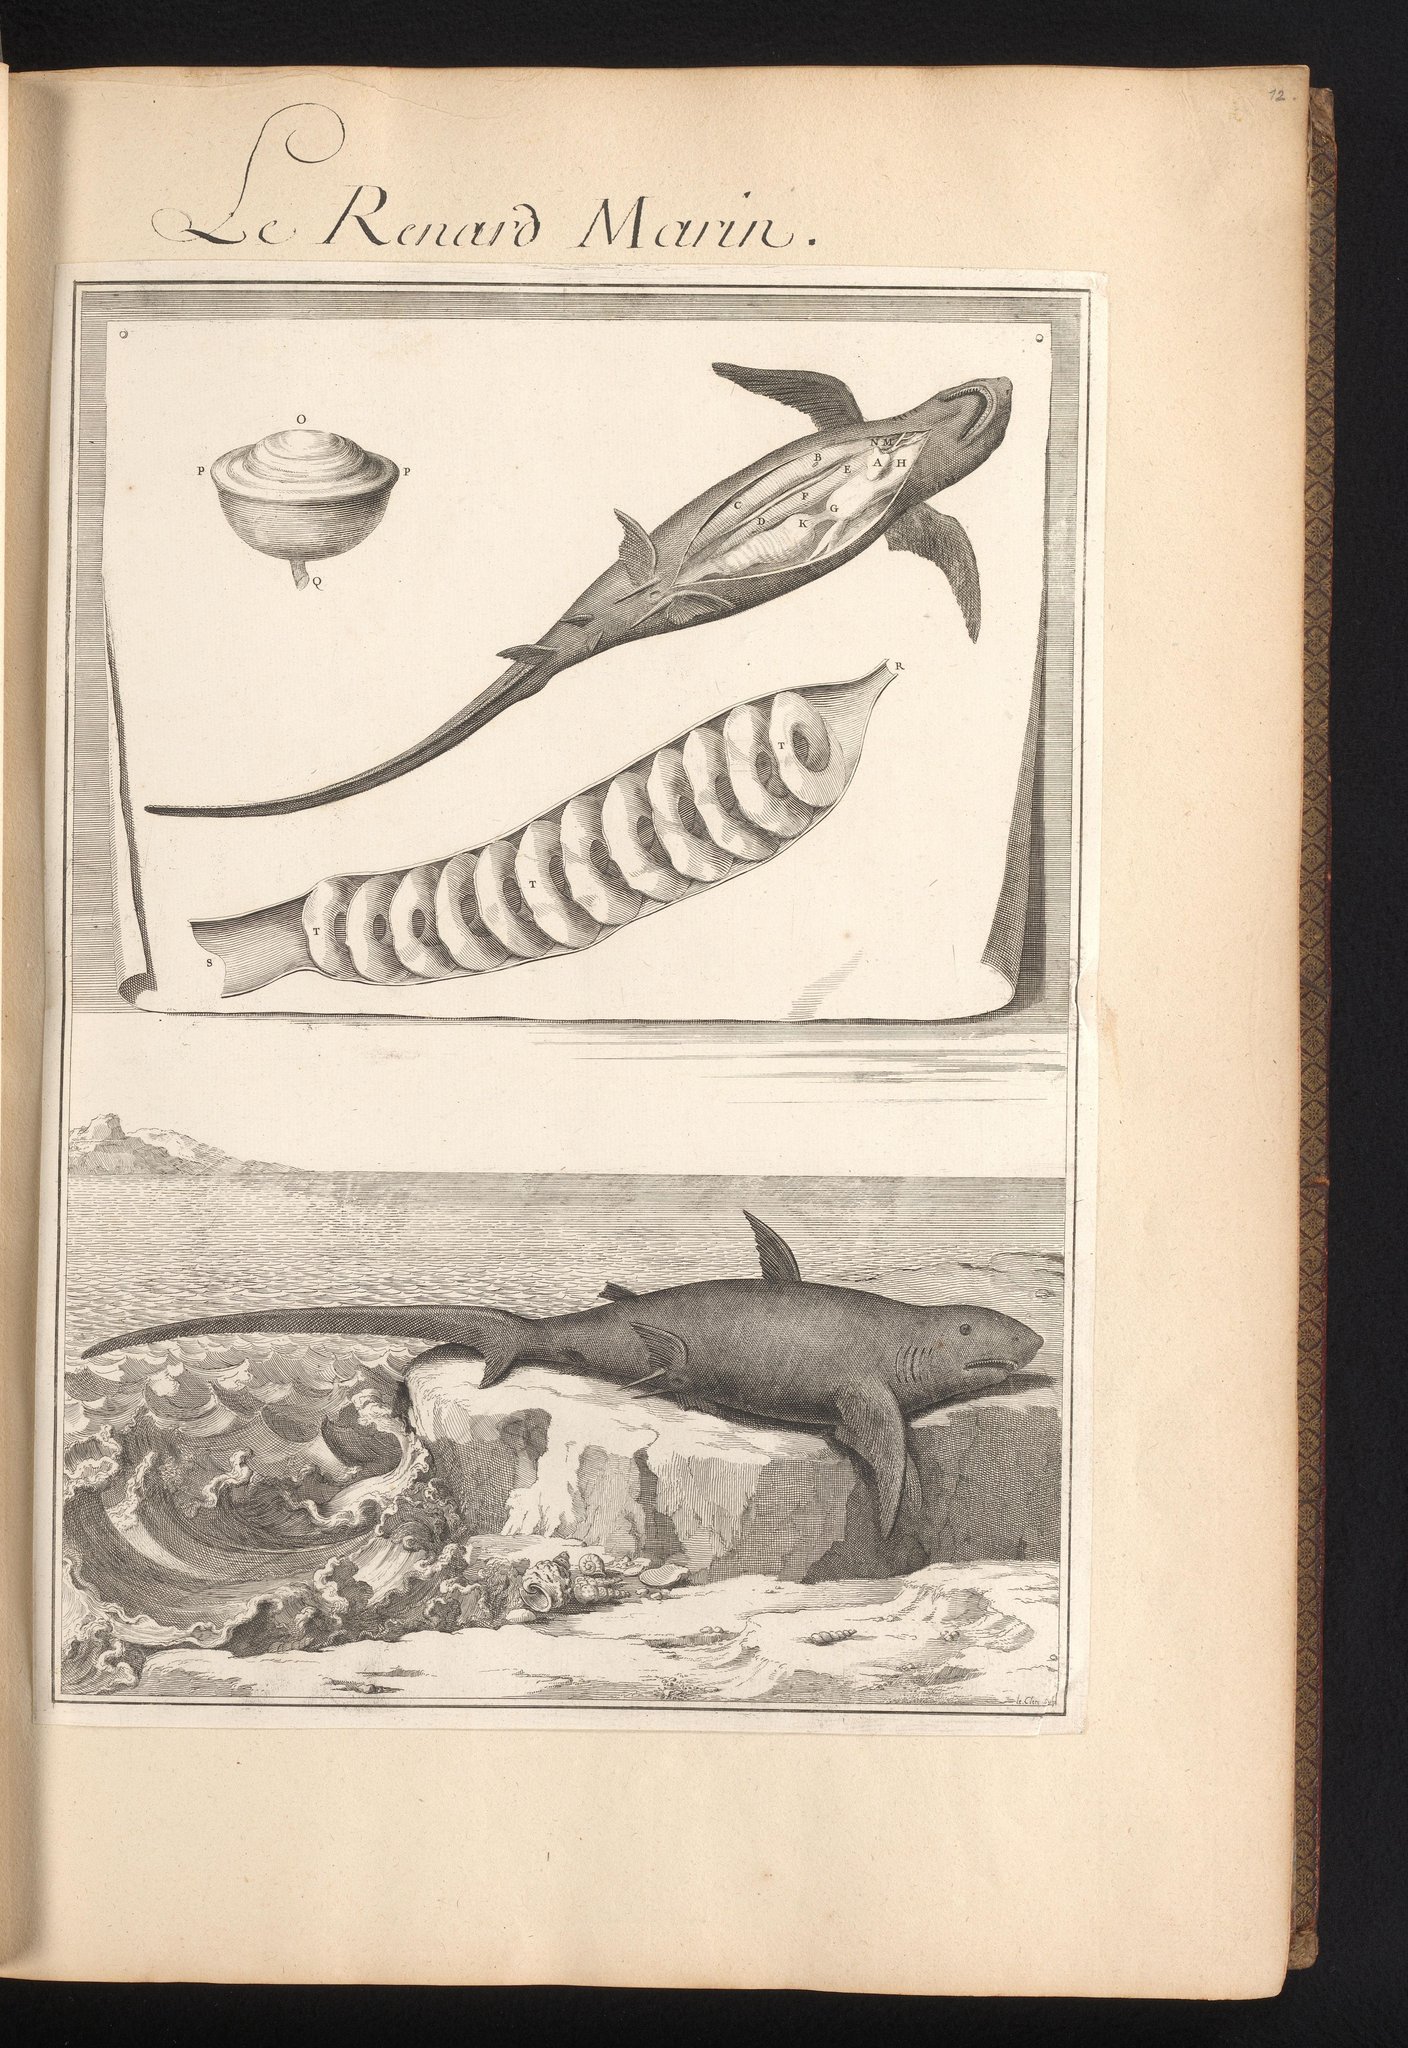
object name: print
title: Aangespoelde haai of voshaai (Alopias vulpinus) aan de kust met bovenaan op een blad de organen van het dier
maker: sébastien leclerc (i)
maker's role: print maker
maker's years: 1637-1714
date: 1671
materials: ink, paper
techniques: engraving, etching, pen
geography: paris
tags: dissection, cartilaginous fishes: shark (+ anatomy of animals), cartilaginous fishes: shark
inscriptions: inscription: ‘Le Renard Marin.’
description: Prent uit: Perrault, Claude. Mémoires pour servir à l'histoire naturelle des animaux. Parijs: Imprimerie Royale, 1671.